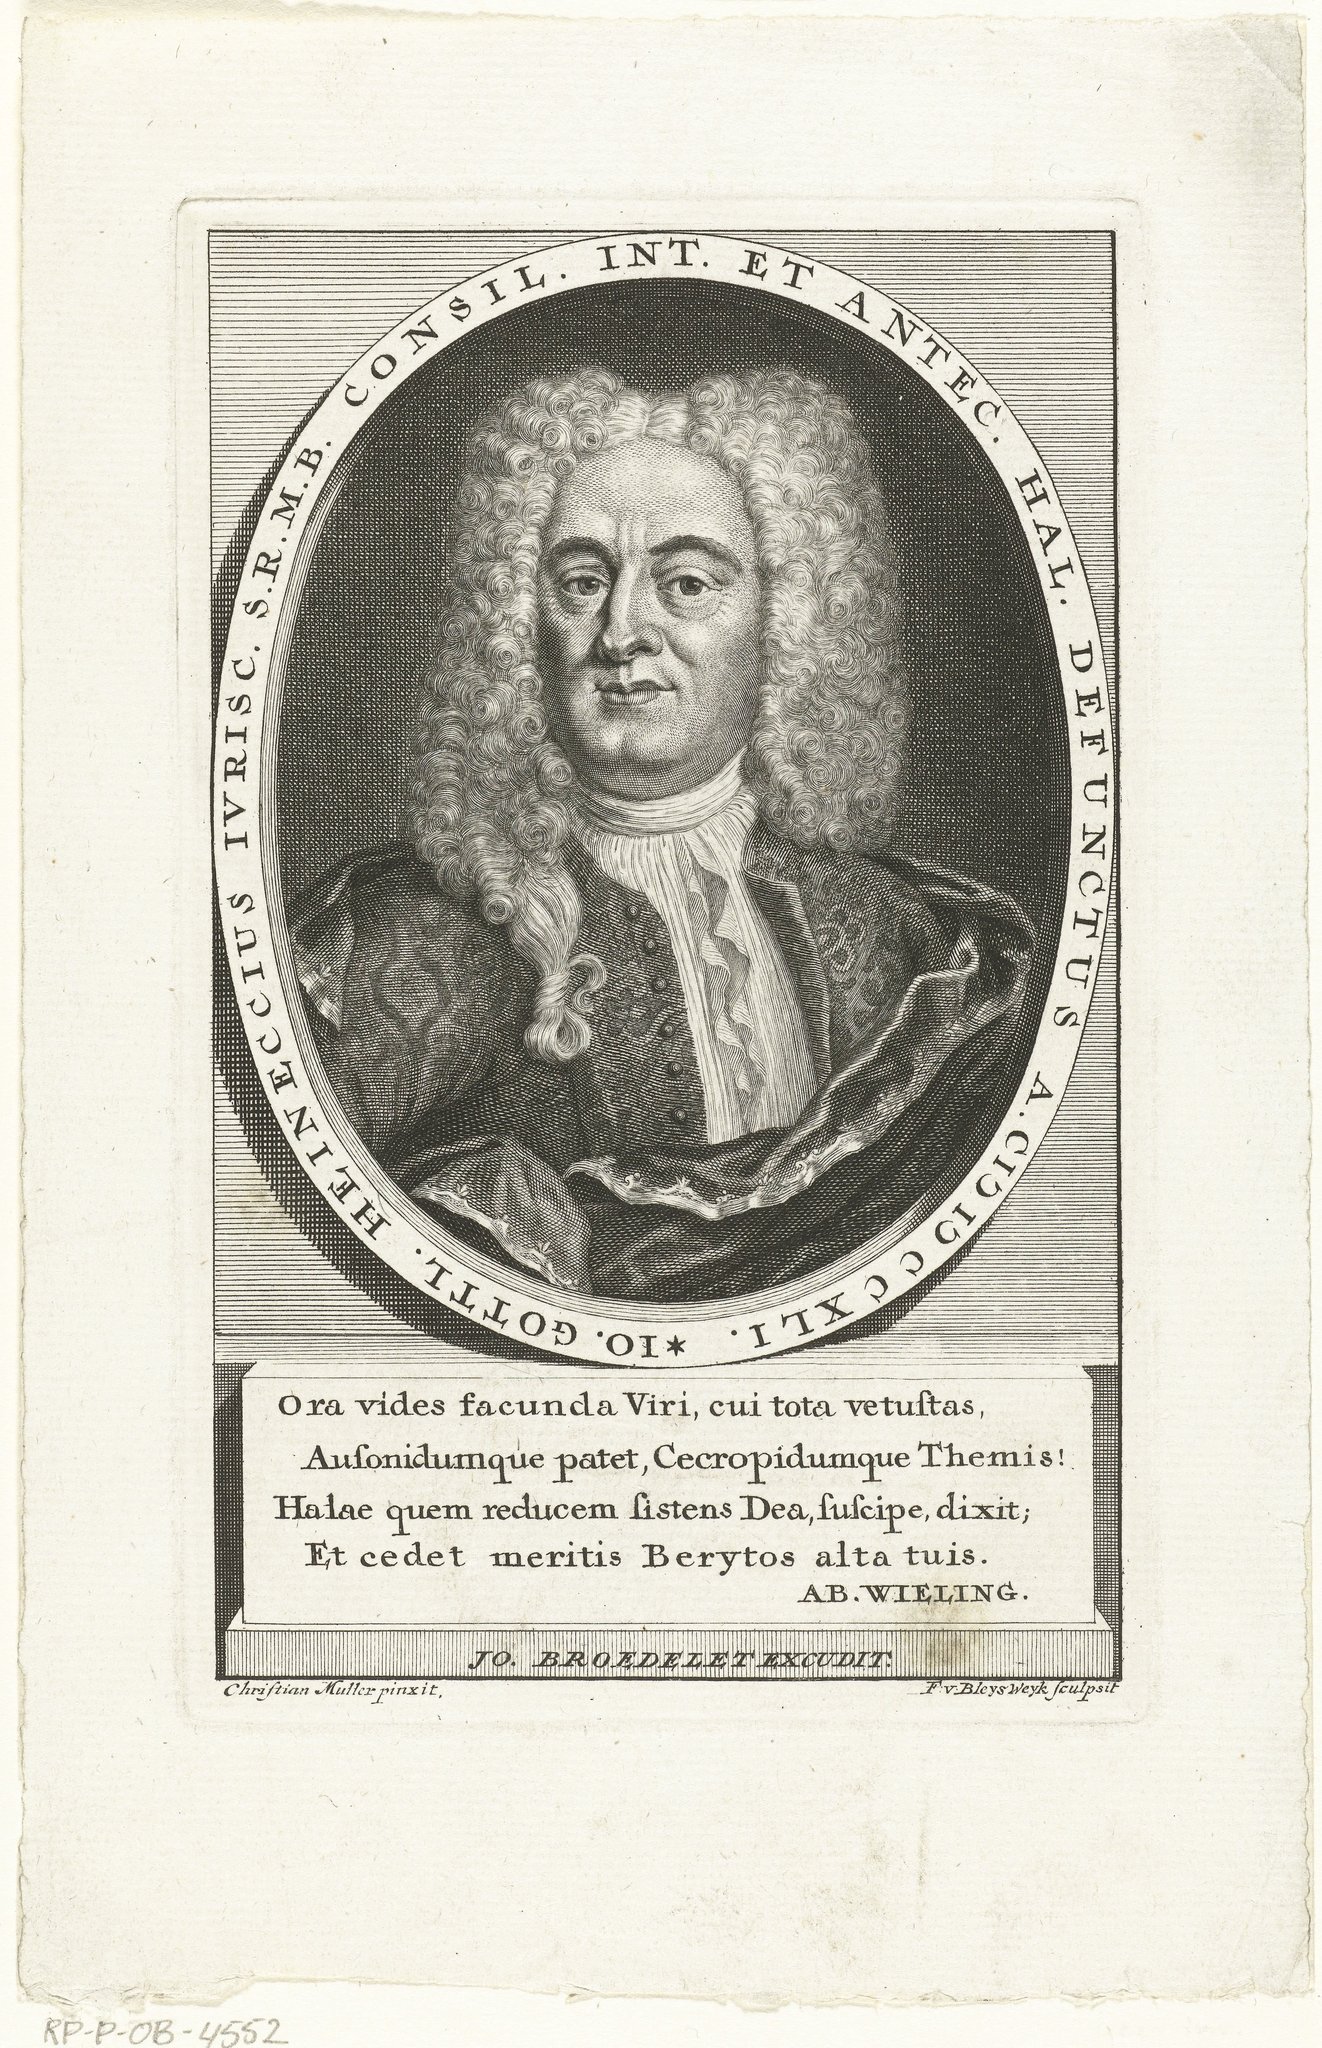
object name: print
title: Portret van jurist Johann Gottlieb Heineccius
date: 1681-1746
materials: paper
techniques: engraving, etching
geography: leiden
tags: thüringen, halle an der saale, filosoof, jurist, johann gottlieb heinecke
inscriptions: collector's mark: Lugt 2228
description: Portret van jurist Johann Gottlieb Heineccius in ovale omlijsting met opschrift. Onder de voorstelling staat een tekst van Ab. Wieling